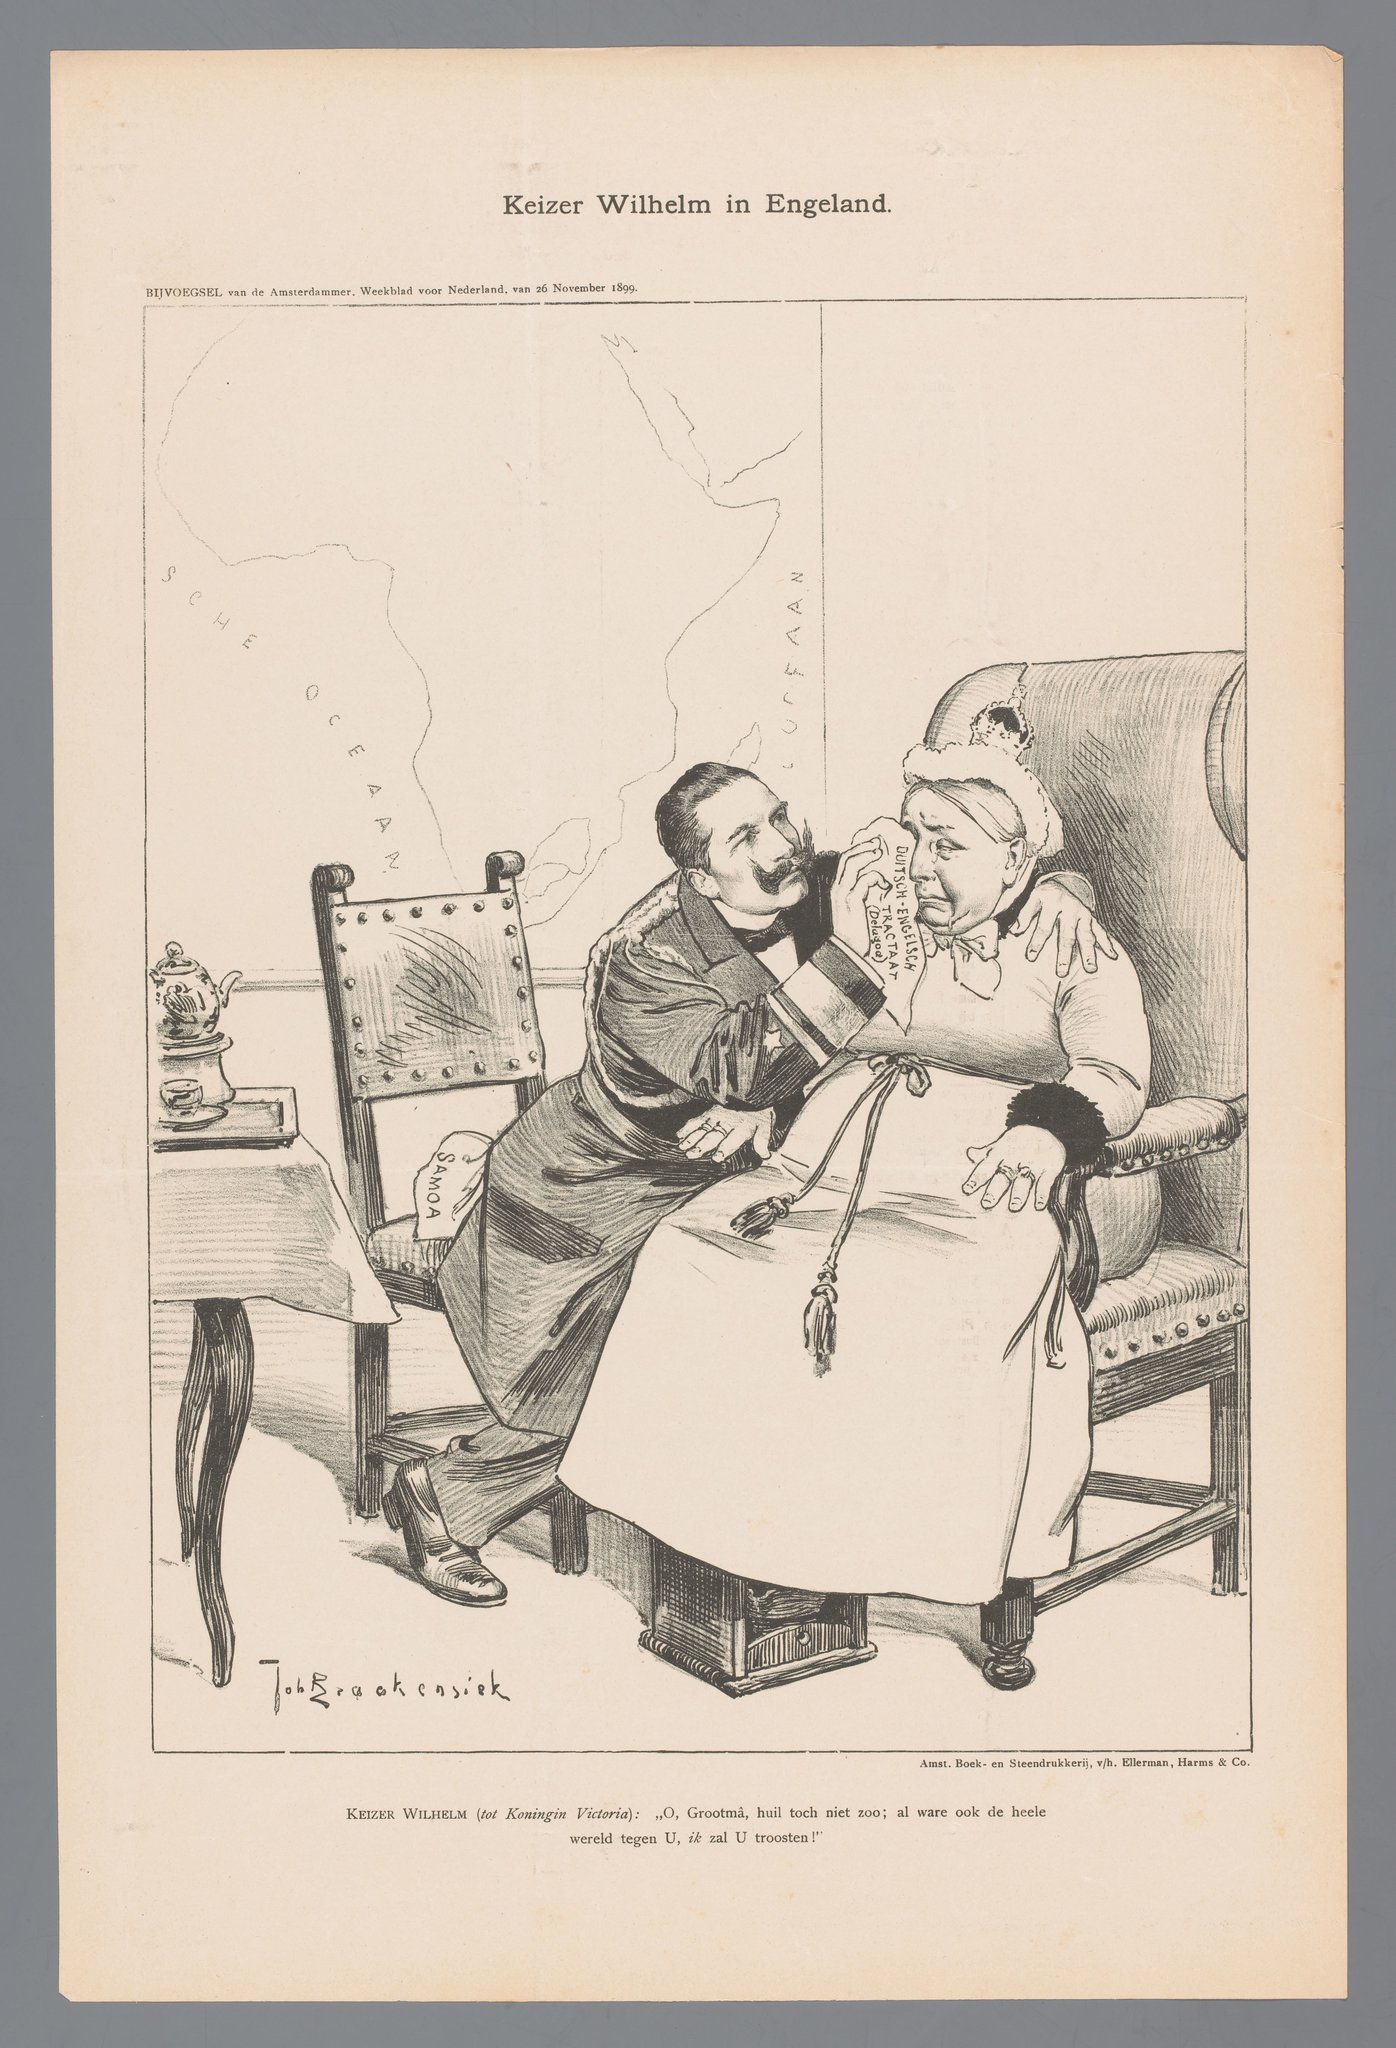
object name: cartoon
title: Keizer Wilhelm in Engeland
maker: johan braakensiek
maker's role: draughtsman, print maker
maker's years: 1858-1940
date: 1899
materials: paper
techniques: lithograph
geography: amsterdam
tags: victoria (koningin van het verenigd koninkrijk en keizerin van india), wilhelm ii (keizer van duitsland), historical persons, ruler, sovereign, political caricatures and satires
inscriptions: date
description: Prent uit het bijvoegsel van: De Amsterdammer. Weekblad voor Nederland, 26 november 1899.